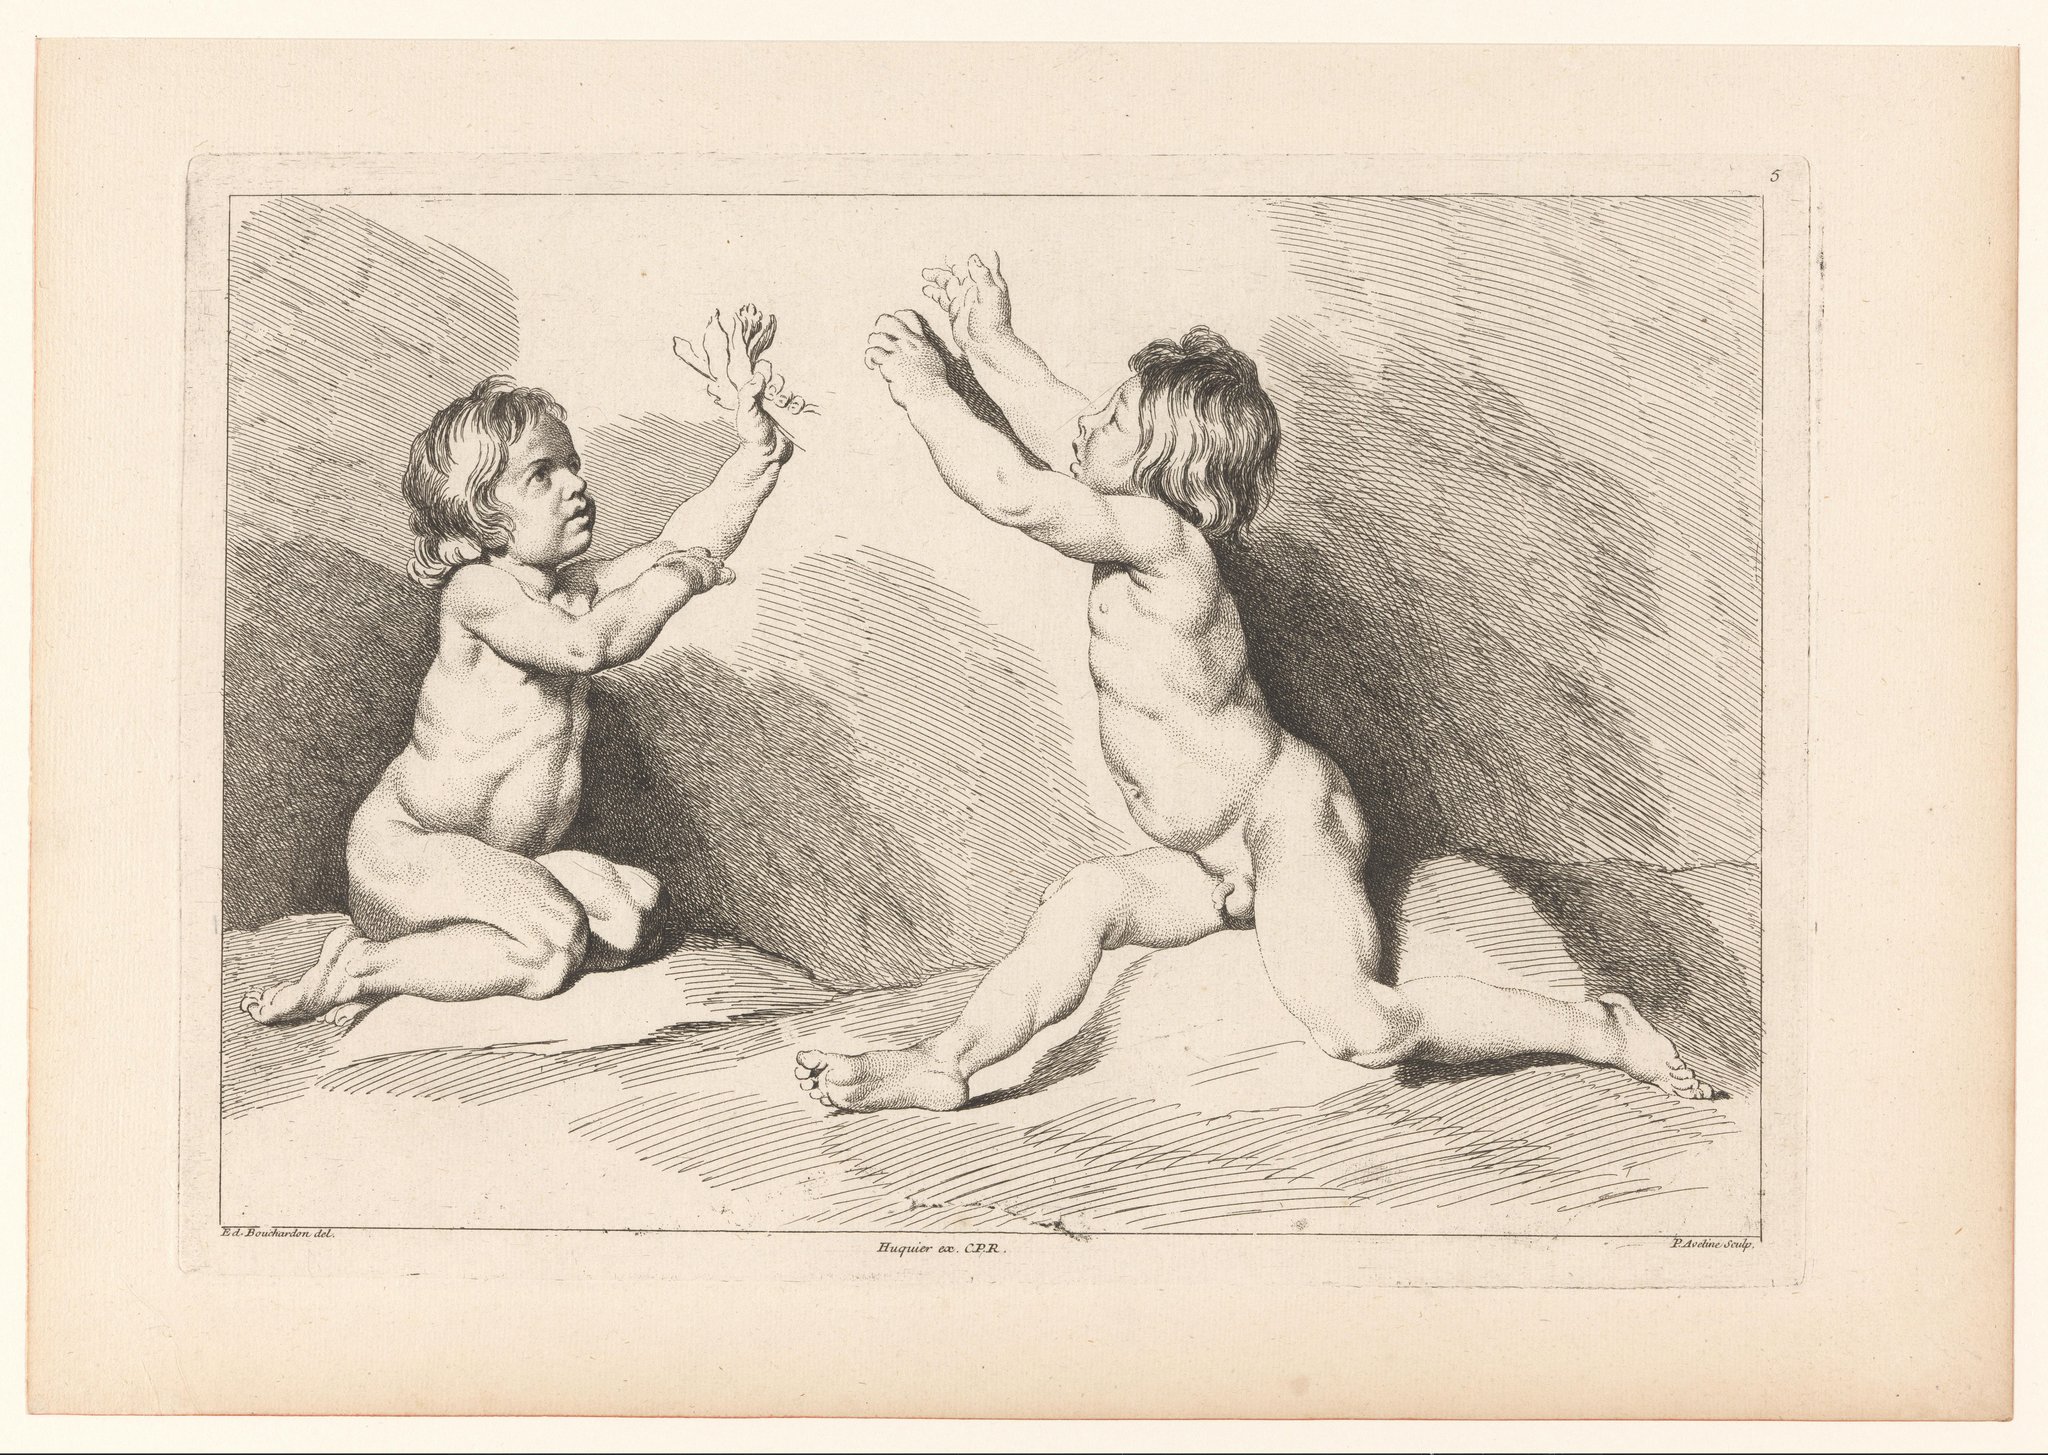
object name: print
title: Nouveau livre d’Enfants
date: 1742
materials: paper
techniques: etching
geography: paris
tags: sitting figure (+ young male (human being))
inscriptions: collector's mark: Lugt 2228, collector's mark: Lugt 2760, number: ‘5’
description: Twee zittende jongetjes die omhoog grijpen. Onderdeel van de serie studies van kinderen.